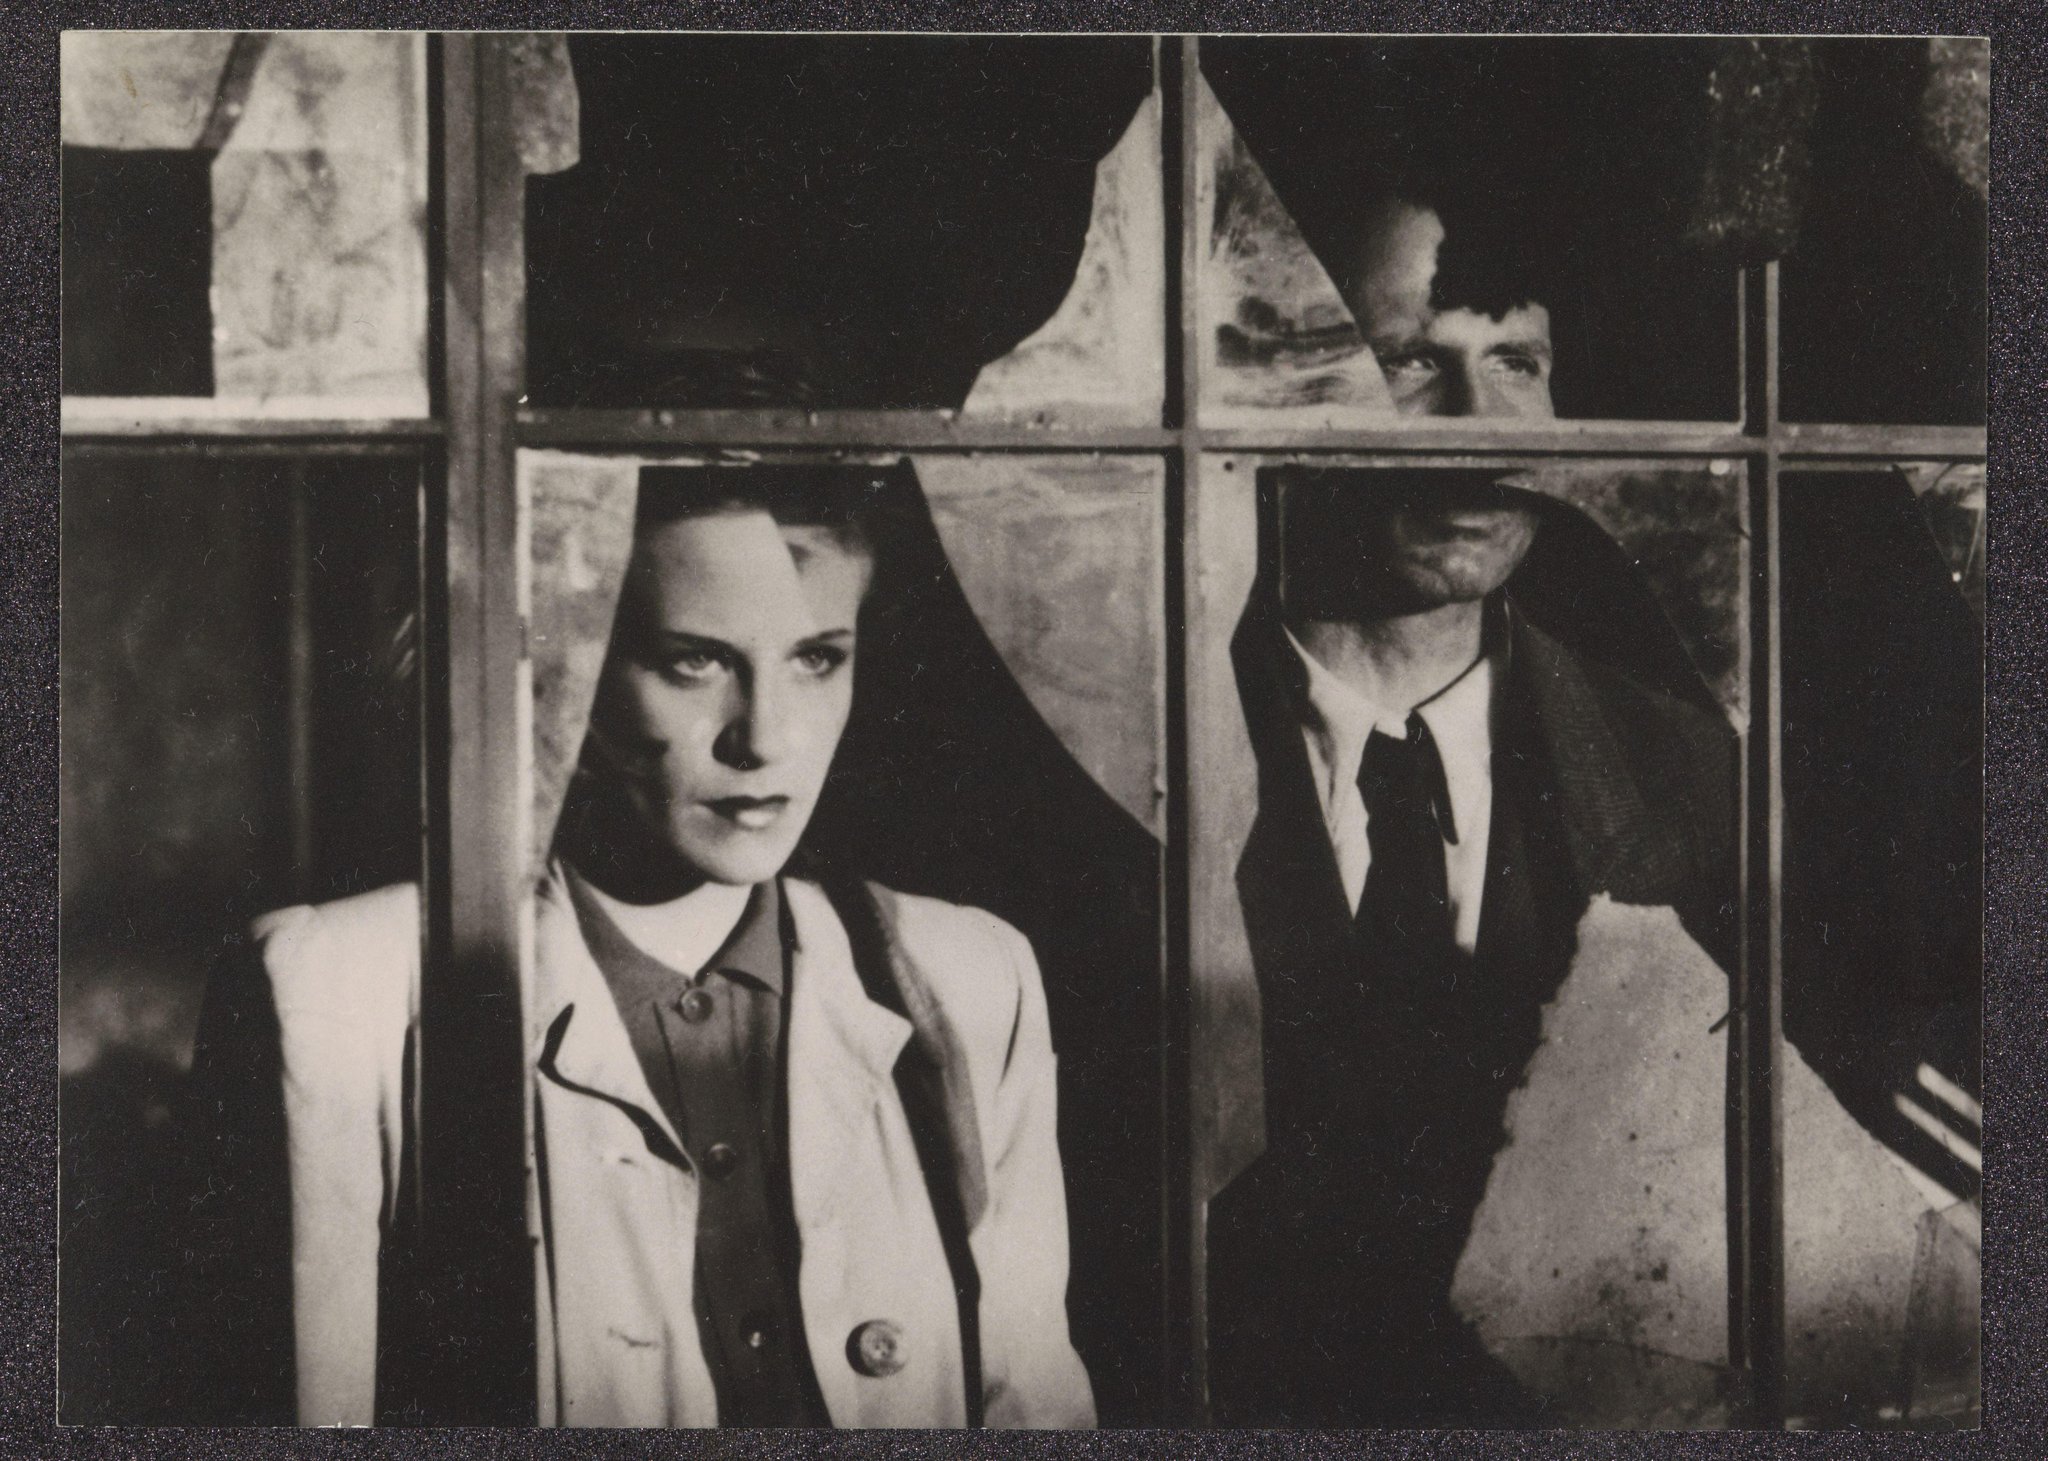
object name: photograph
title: Still uit de film Die Mörder sind unter uns, met acteurs Hildegard Knef en Ernst Wilhelm Borchert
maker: Anonymous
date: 1946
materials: paper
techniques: gelatin silver print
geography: berlin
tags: berlin, window, film actor (on the screen)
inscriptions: inscription: ‘Hilde Knef +/ Wilhelm Borchert’, stamp: ‘Nederlands Filmmuseum/ Amsterdam’, inscription: ‘Die Mörder sind unter uns/ O-Duitsl. 1946/ Wolfgang Staudte’